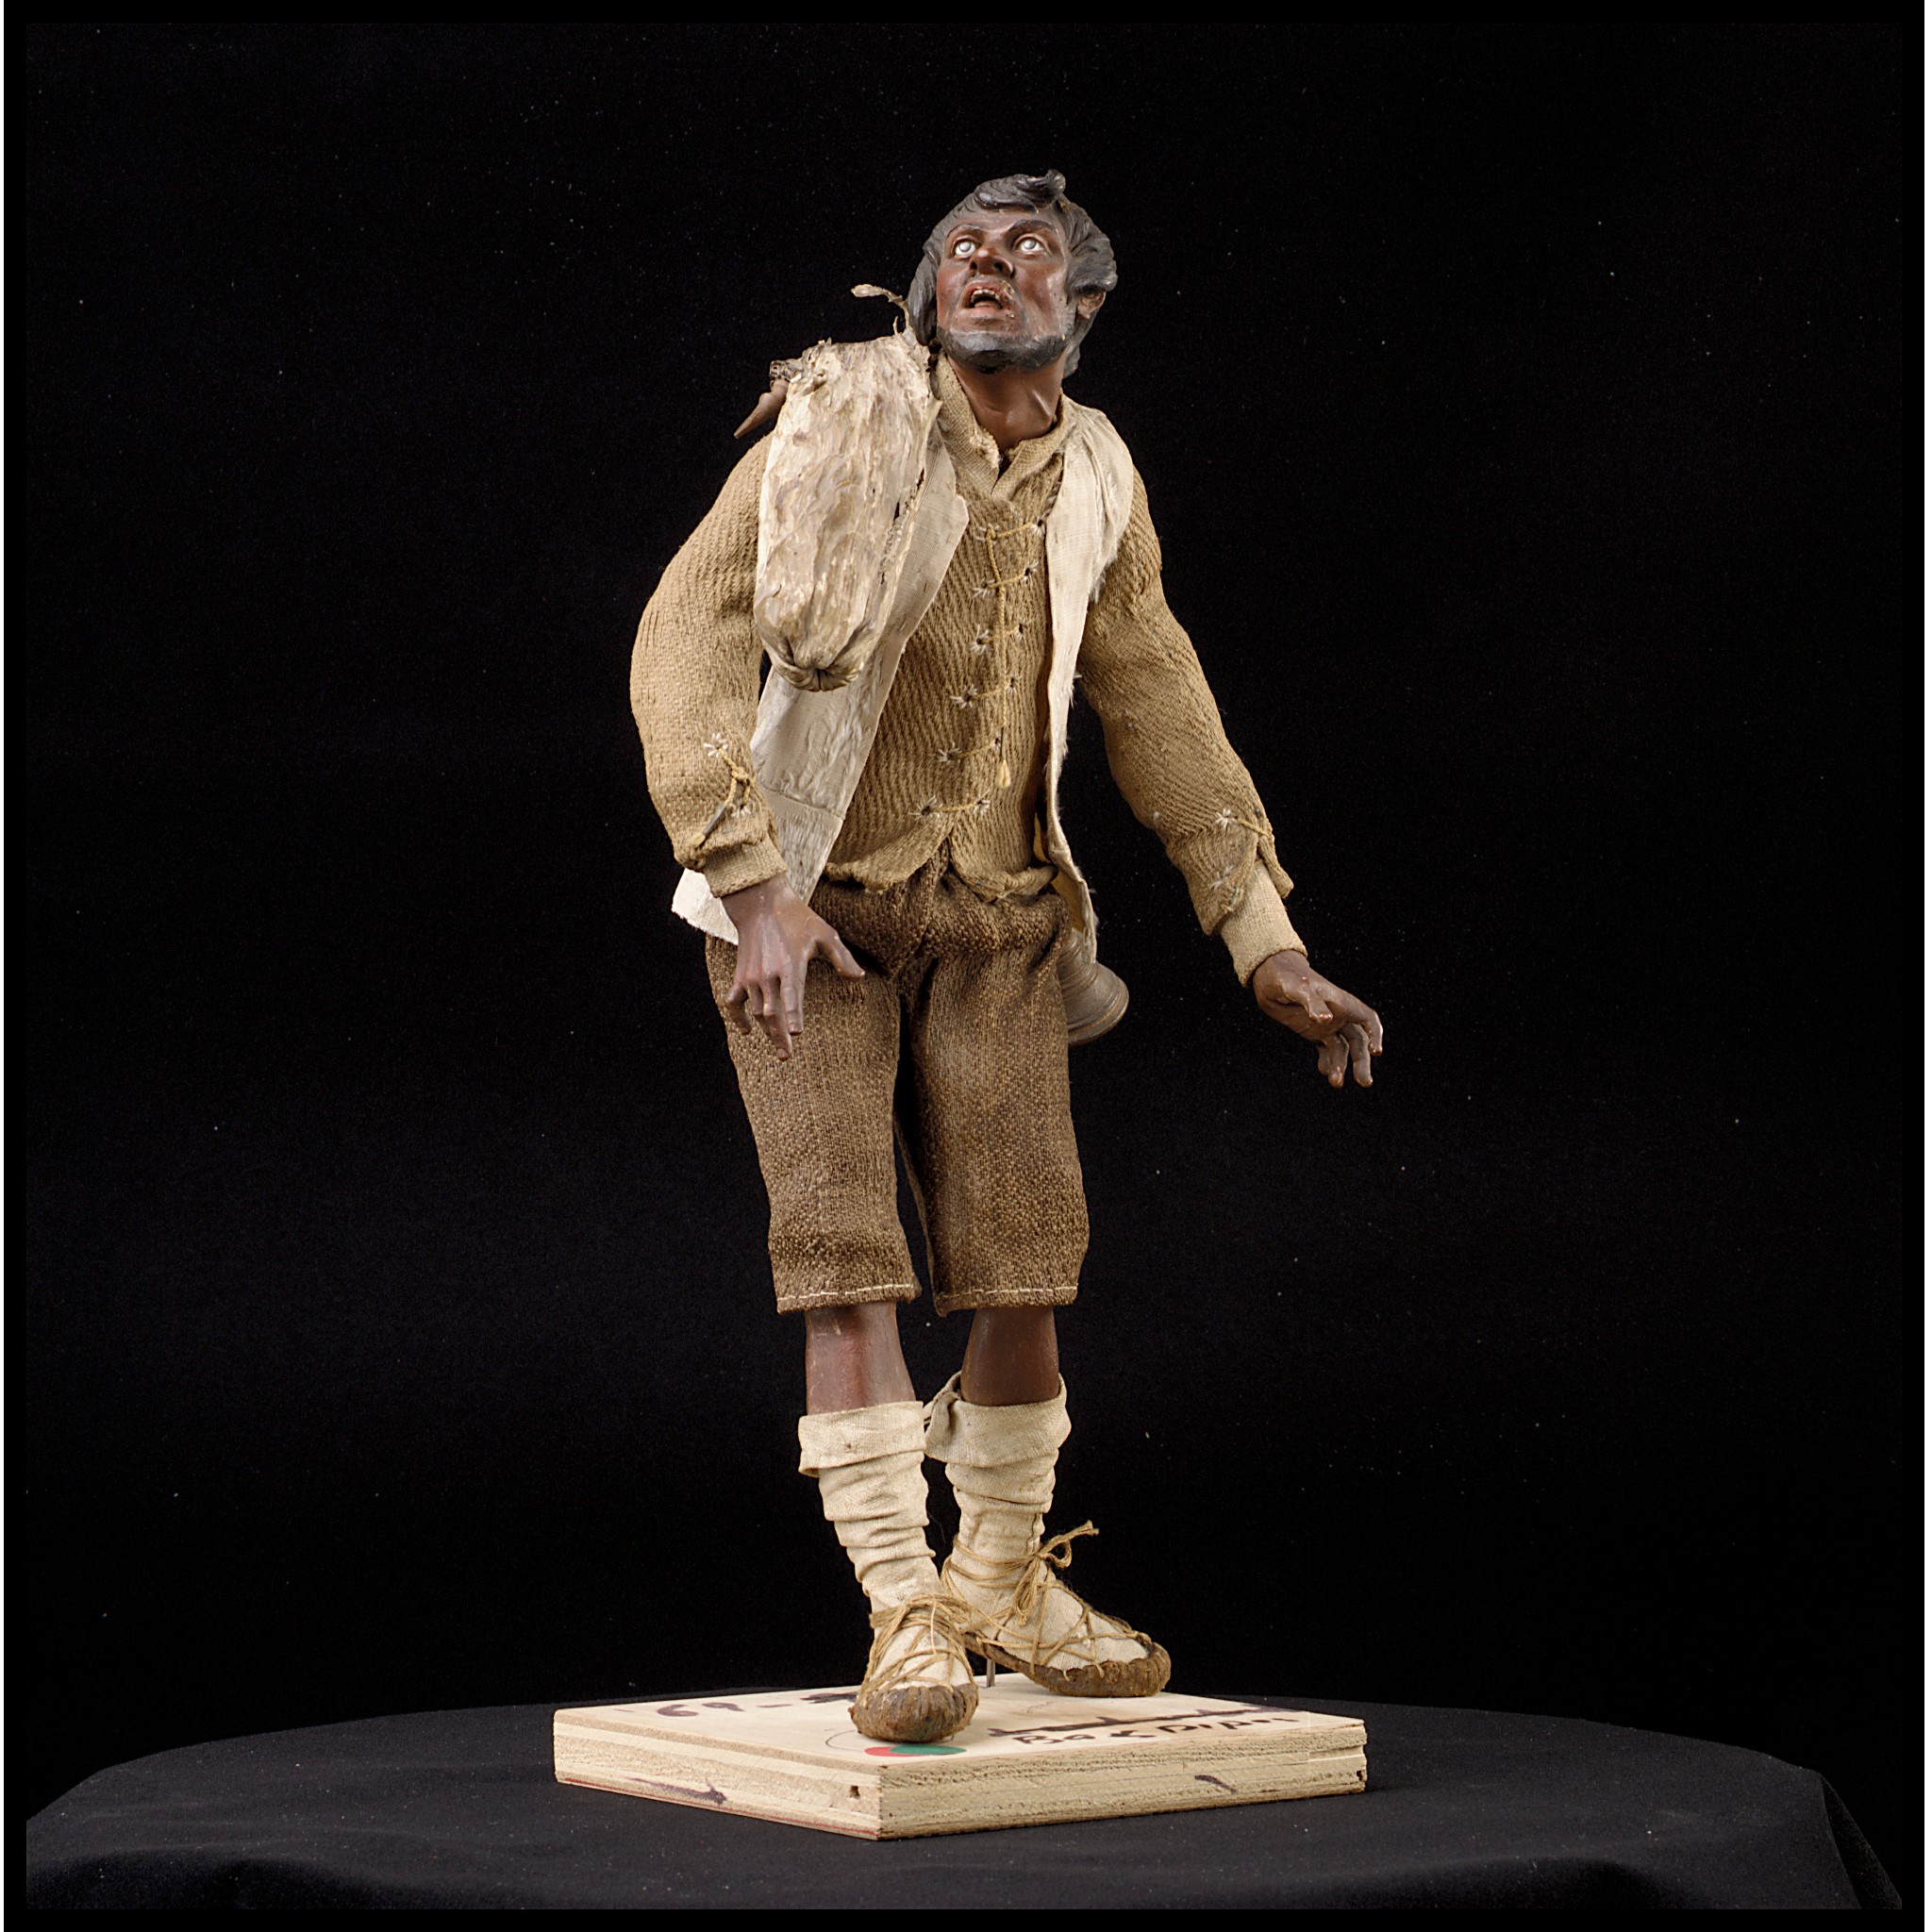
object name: crèche figure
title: Man carrying bagpipes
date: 1701-1800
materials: textile, leather, fiber, terracotta, wood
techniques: polychrome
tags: men,bagpipes